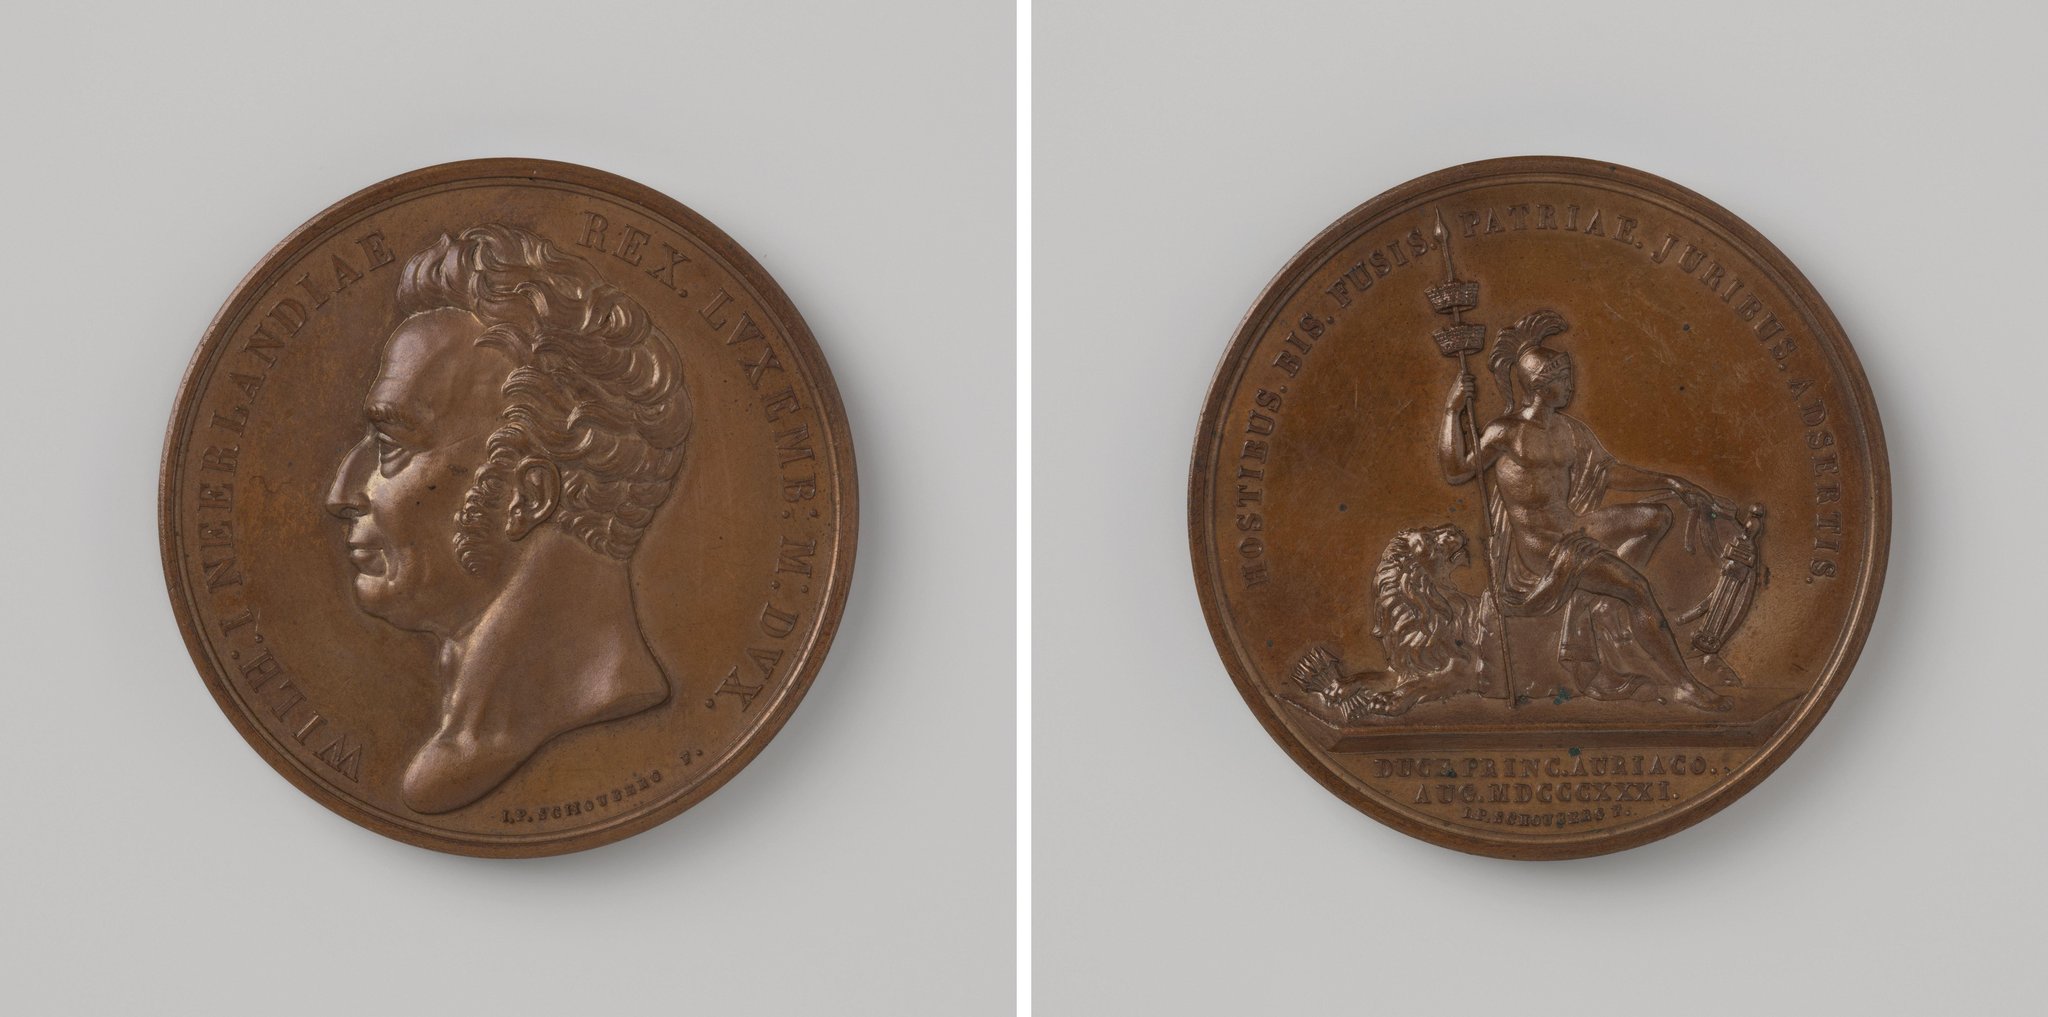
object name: history medal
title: Tiendaagse veldtocht 1831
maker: johannis petrus schouberg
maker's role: die cutter, draughtsman, print maker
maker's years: 1798-1864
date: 1831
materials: bronze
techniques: striking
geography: utrecht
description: Bronzen penning, op de voorzijde het portret van Koning Willem I naar links met omschrift, op de keerzijde een zittende soldaat in antieke kleding, met een speer waaraan twee stedekronen, waarnaast een liggende leeuw met pijlenbundel.